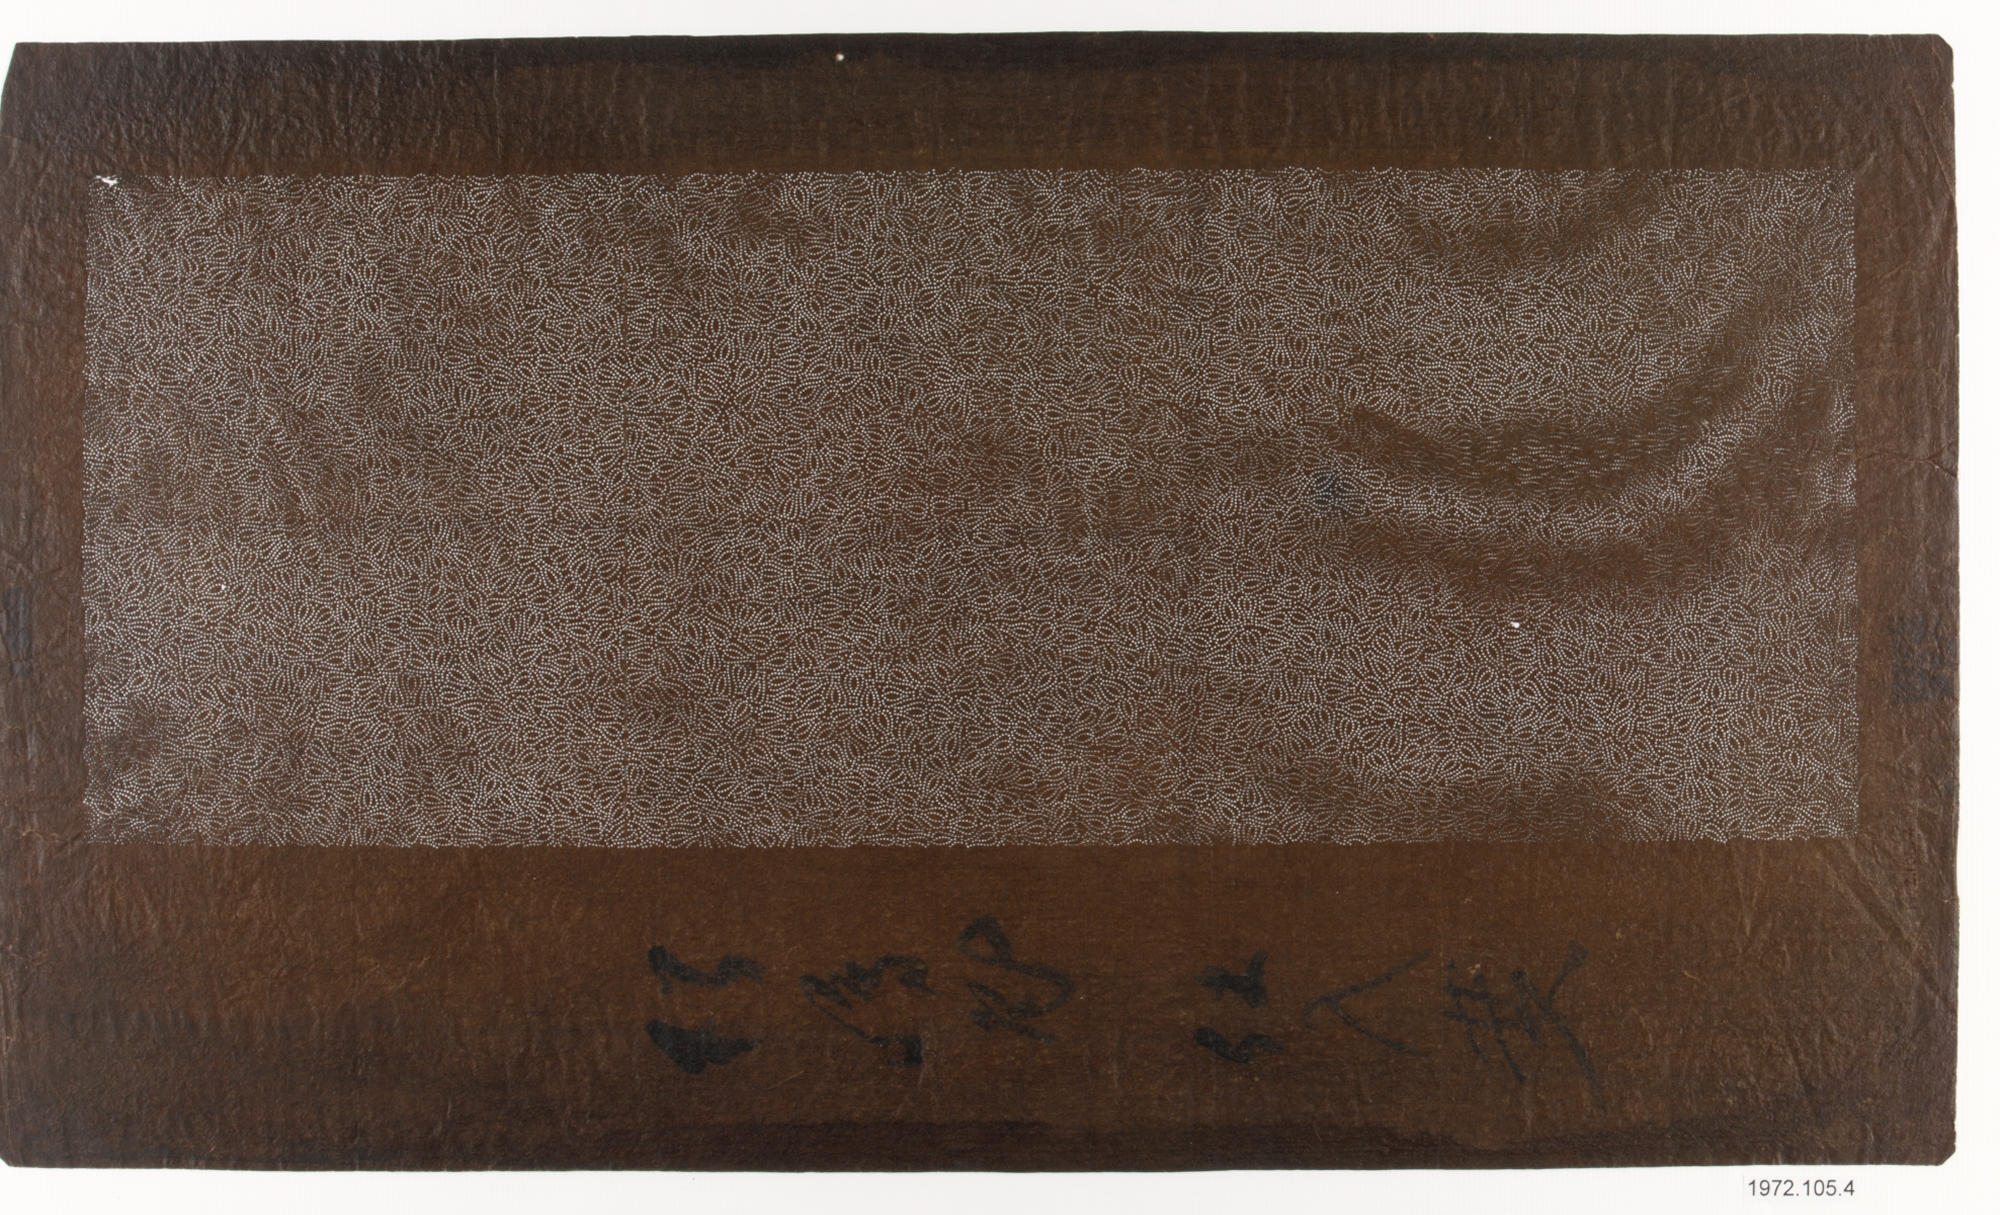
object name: stencil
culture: japanese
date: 1701-1900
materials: paper